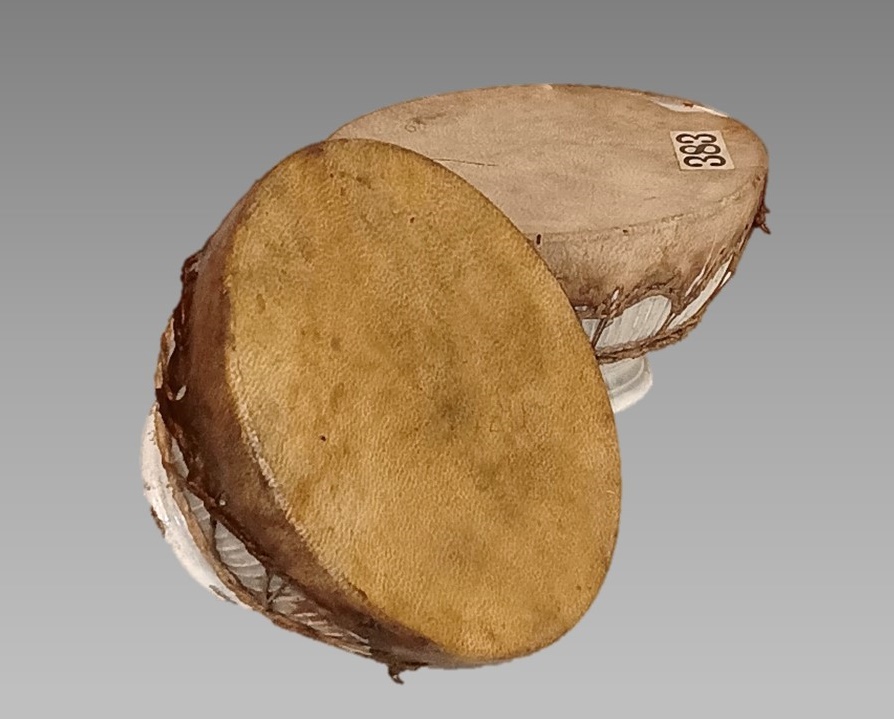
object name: naqqareh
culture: syrian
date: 1867-1900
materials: clay, parchment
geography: syria